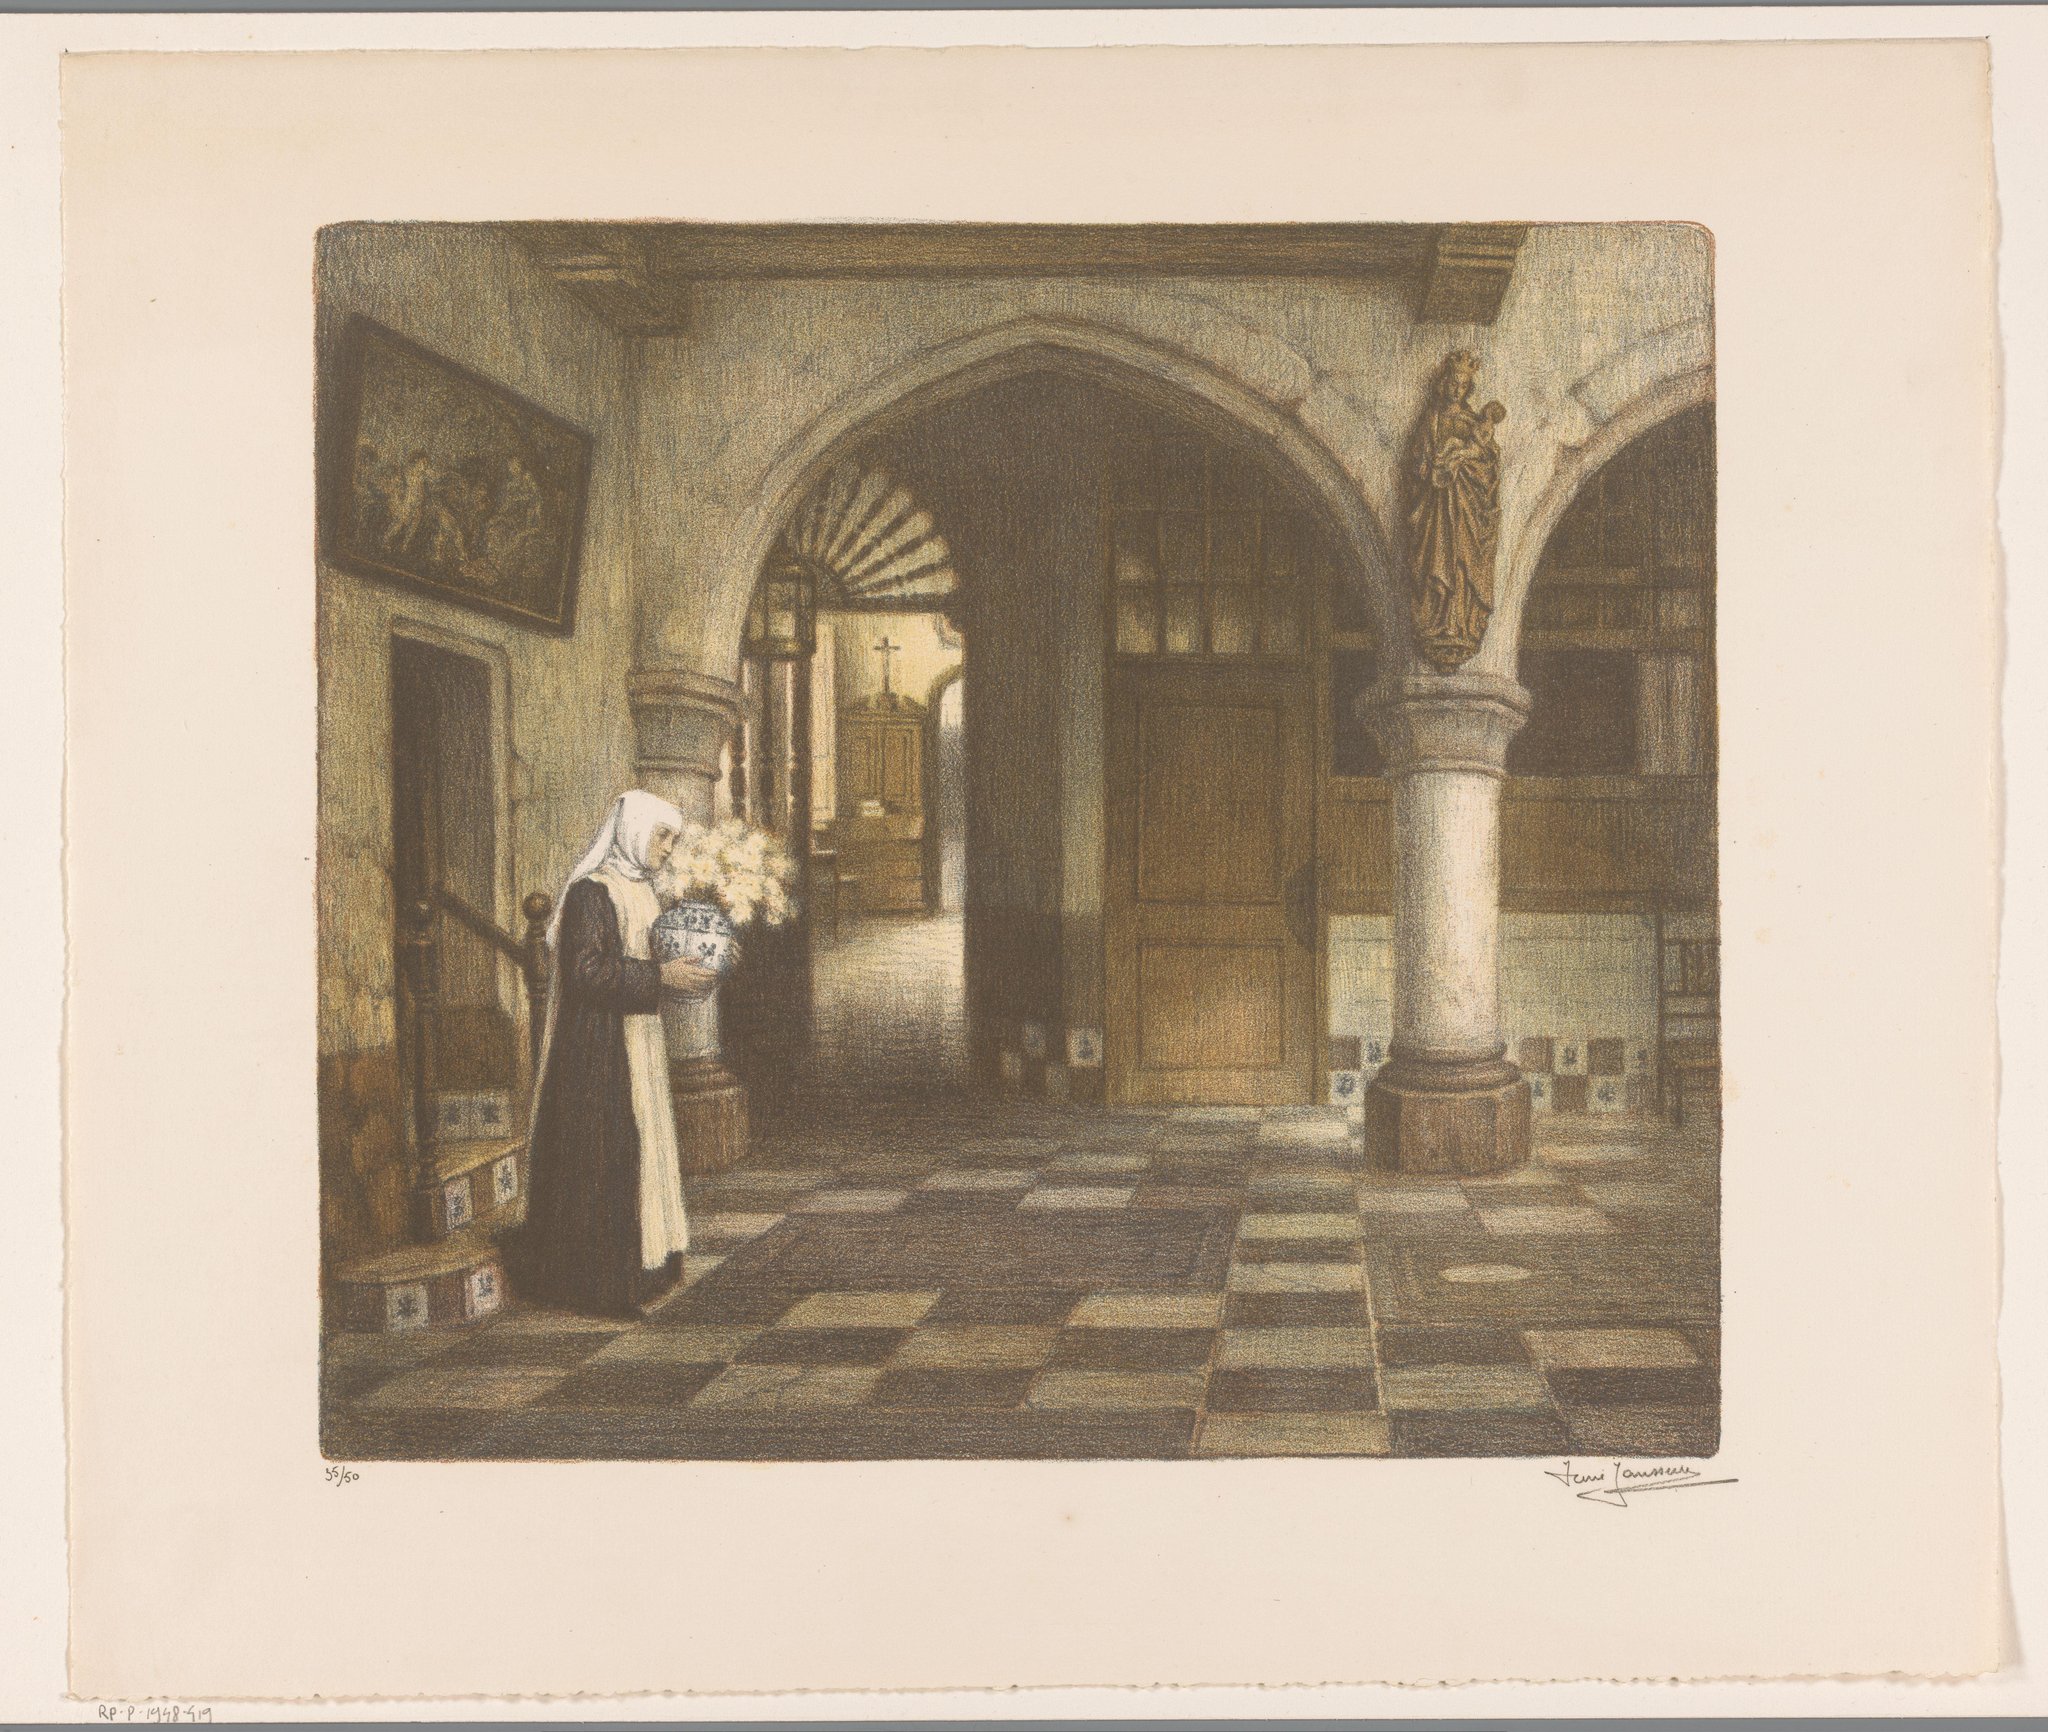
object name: print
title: Non in een kloosterhal met een bloemenvaas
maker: rené janssens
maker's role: draughtsman, print maker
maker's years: 1870-1936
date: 1880-1936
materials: paper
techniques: lithograph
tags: nun(s), abbey, monastery, convent ~ roman catholic church, flowers in a vase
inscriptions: collector's mark: Lugt 2228